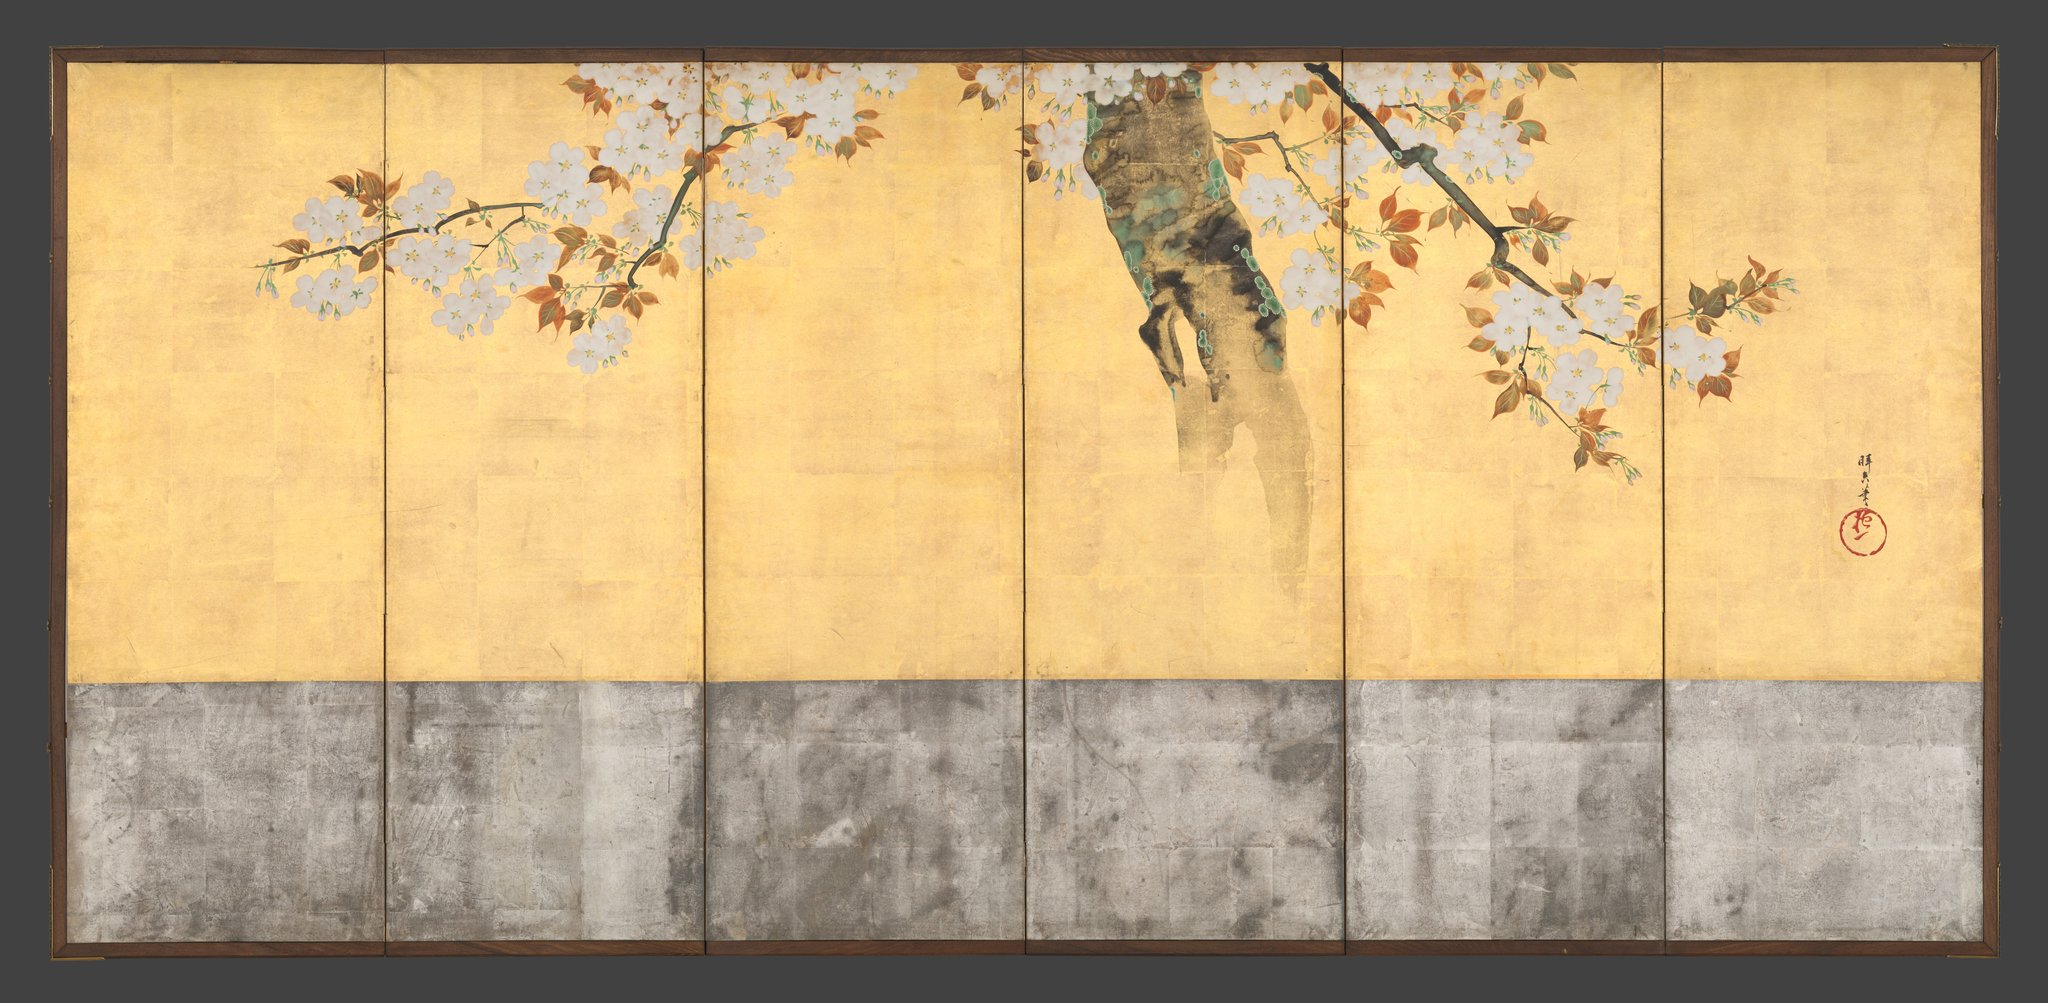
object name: screen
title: Blossoming Cherry Trees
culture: japanese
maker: sakai hōitsu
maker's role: artist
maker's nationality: japanese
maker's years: 1761-1828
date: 1805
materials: gold leaf, ink, panel, paper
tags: flowers,leaves,trees